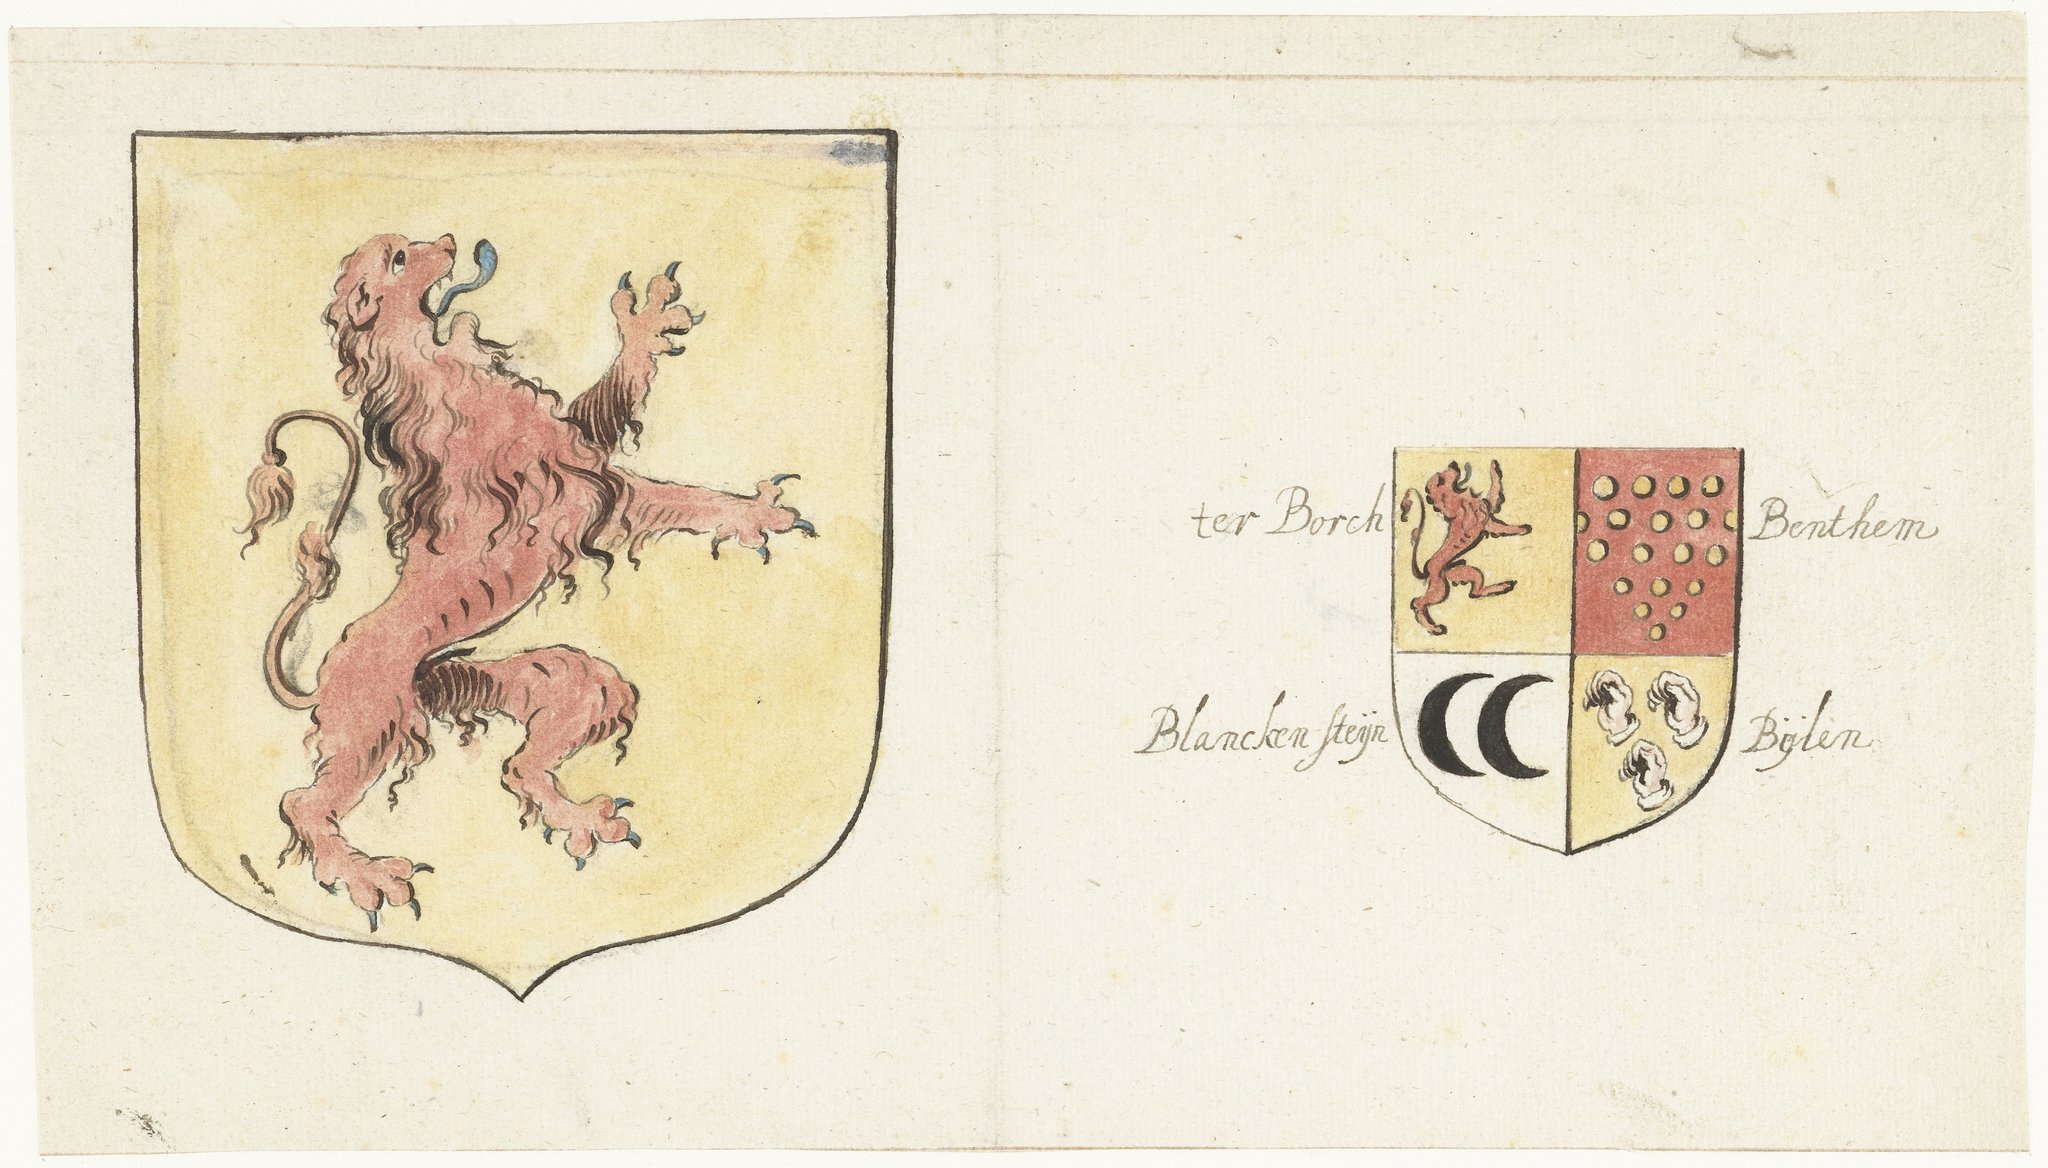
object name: drawing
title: Twee wapenschilden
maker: gesina ter borch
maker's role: draughtsman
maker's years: 1633-1690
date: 1660-1669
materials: chalk, ink, paper, watercolor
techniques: brush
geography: zwolle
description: Links het wapenschild van de Ter Borch familie, rechts een wapenschild met beide wapens van Gesina's betovergrootouders: Ter Borch en Blanckensteijn links en Benthem en Bijlen rechts.